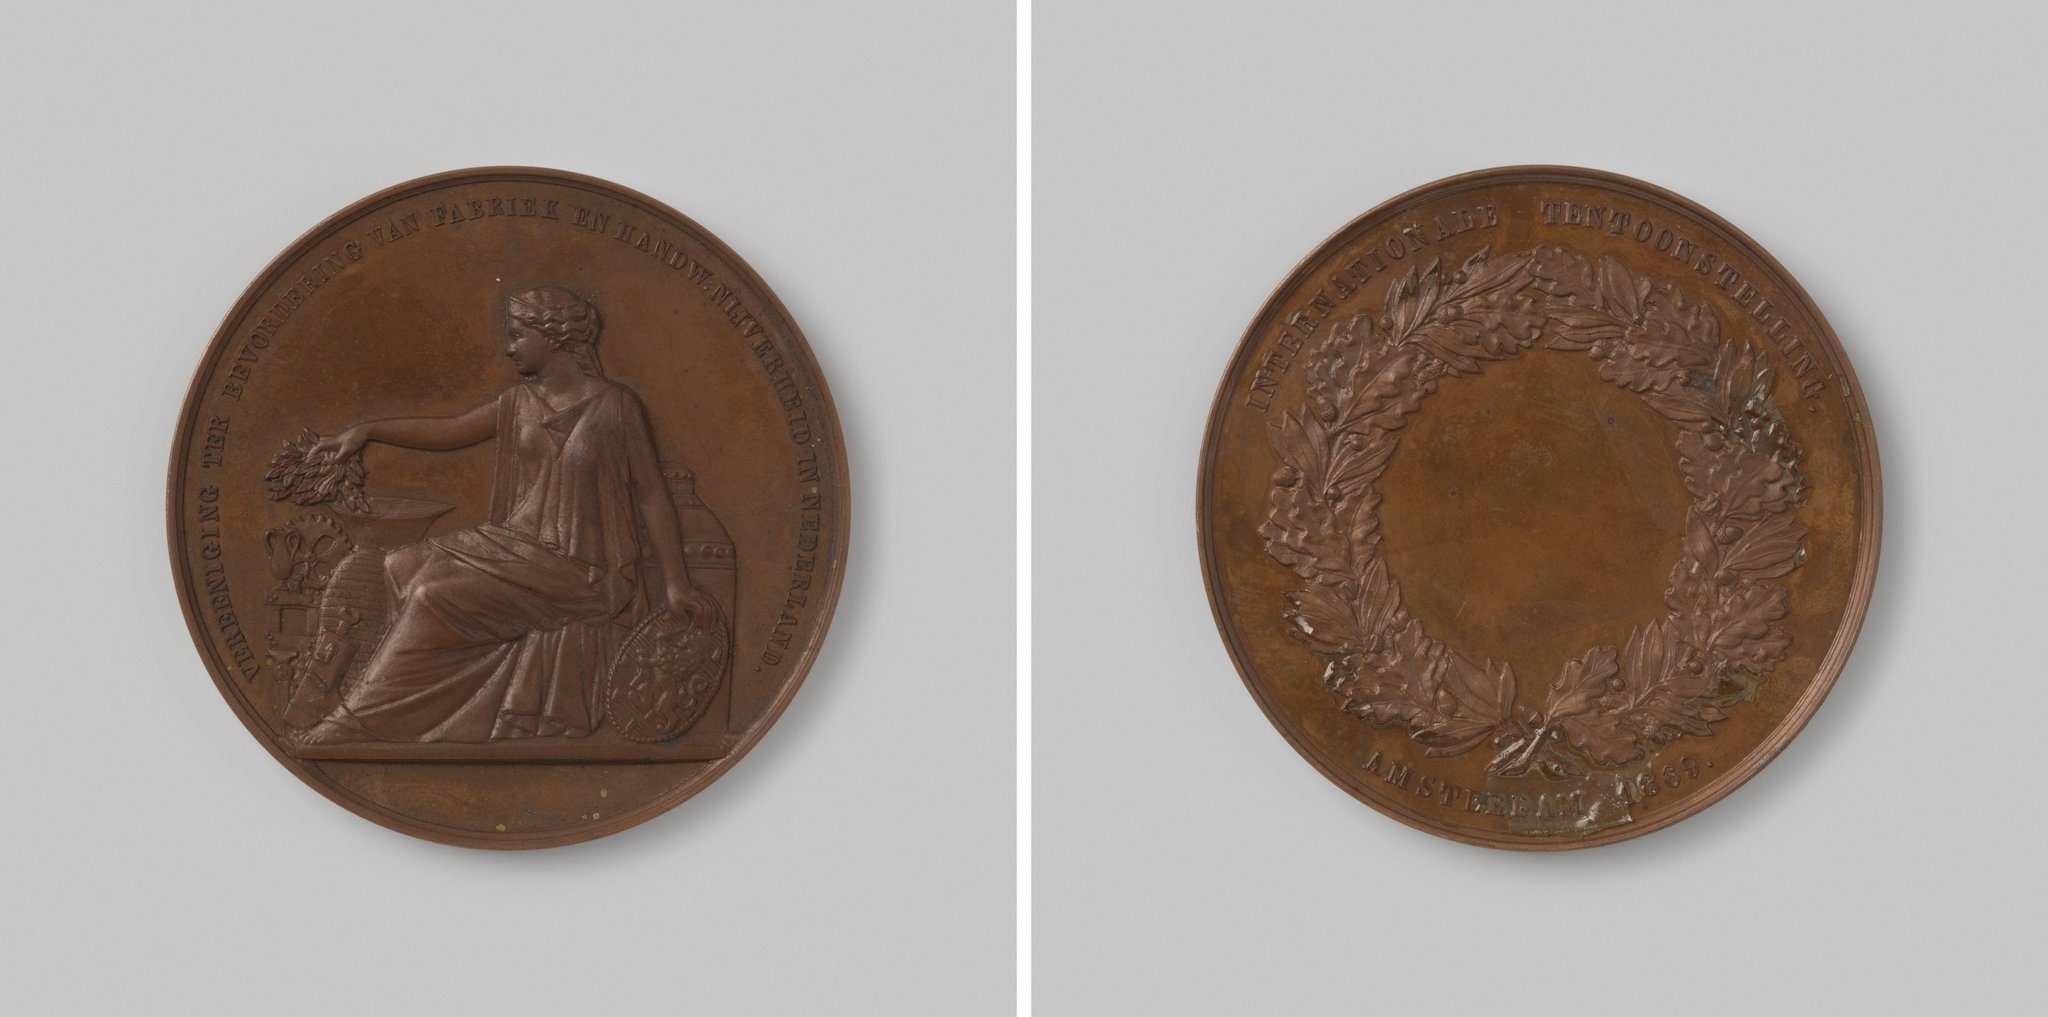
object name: history medal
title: Internationale Tentoonstelling te Amsterdam 1869 namens de Vereeniging ter Bevordering van Fabriek en Handwerknijverheid in Nederland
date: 1869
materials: bronze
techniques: striking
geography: utrecht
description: Bronzen penning, op de voorzijde de naar links zittende Nederlandse Maagd die een stapel nijverheidsattributen lauwert, met omschrift, op de keerzijde een inscriptieveld tussen verweven eiken en lauwertakken, met omschrift.